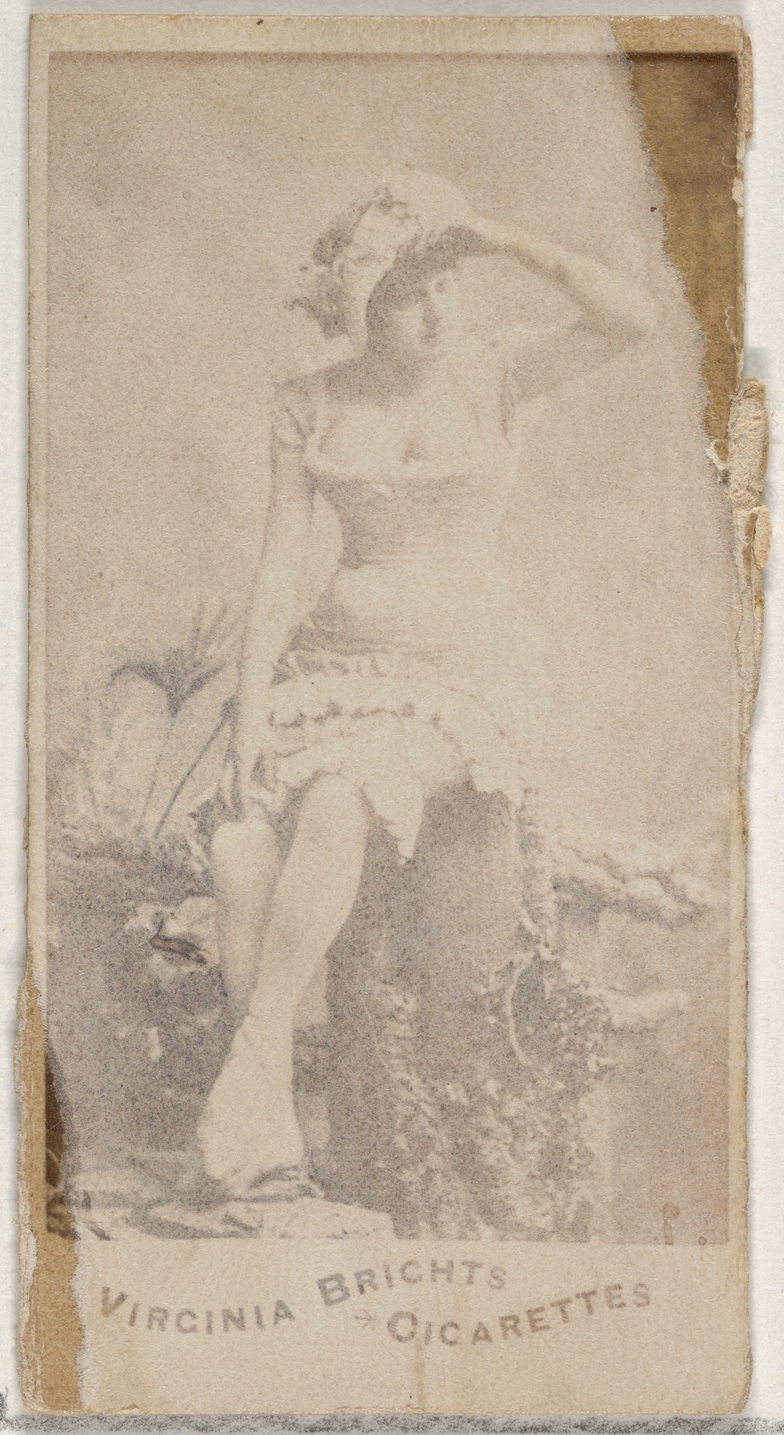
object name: photograph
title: From the Actors and Actresses series (N45, Type 5) for Virginia Brights Cigarettes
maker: allen & ginter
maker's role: publisher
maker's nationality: american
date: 1888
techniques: albumen silver print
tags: portraits,women,actresses